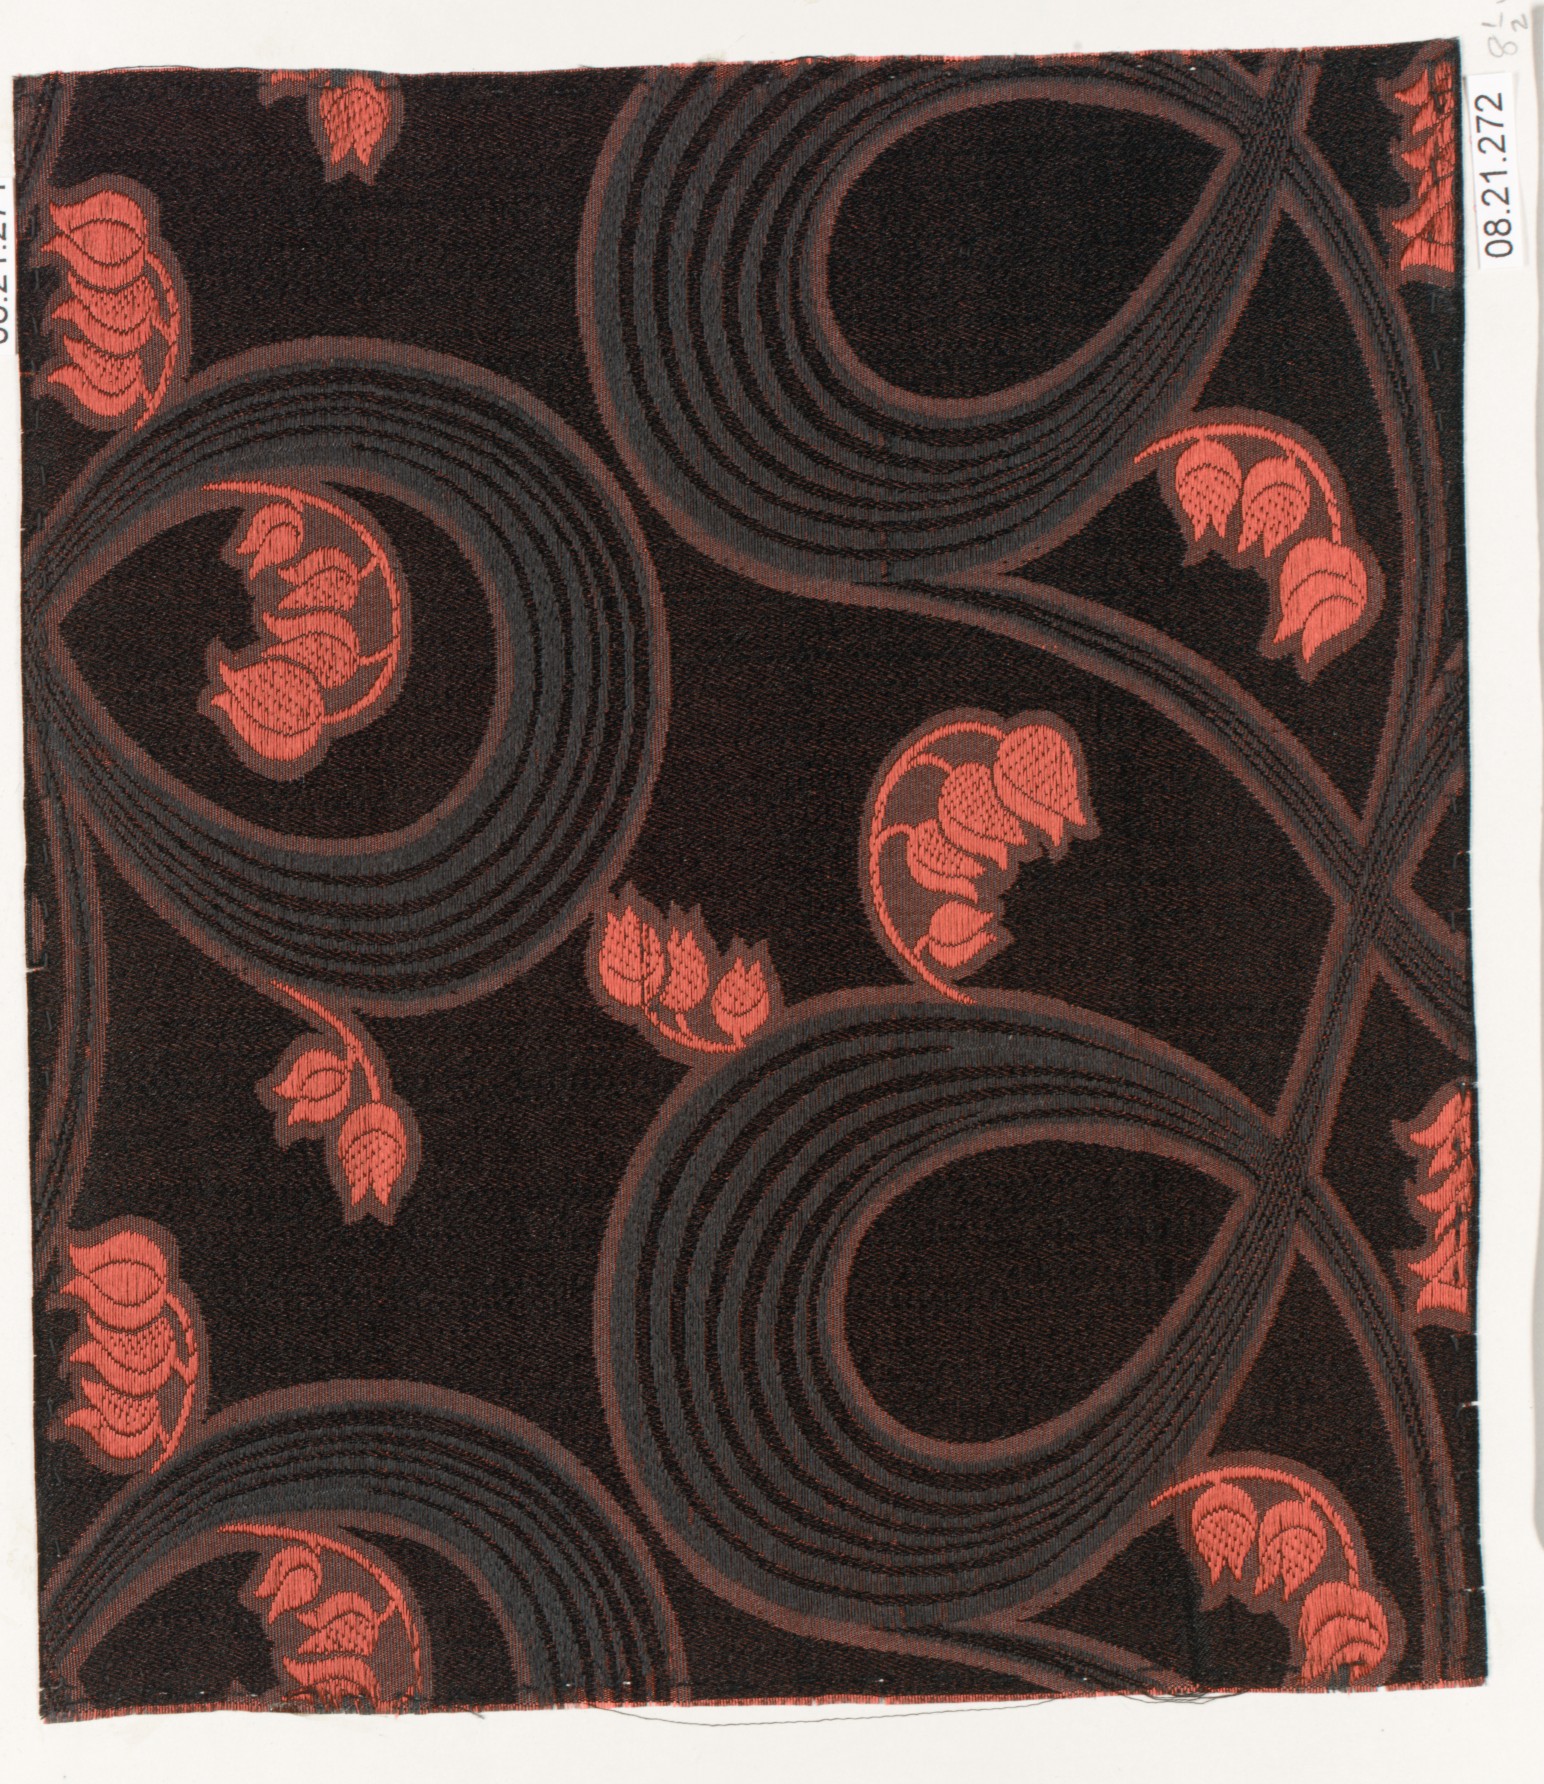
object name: textile sample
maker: Anonymous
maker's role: designer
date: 1900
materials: silk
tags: flowers